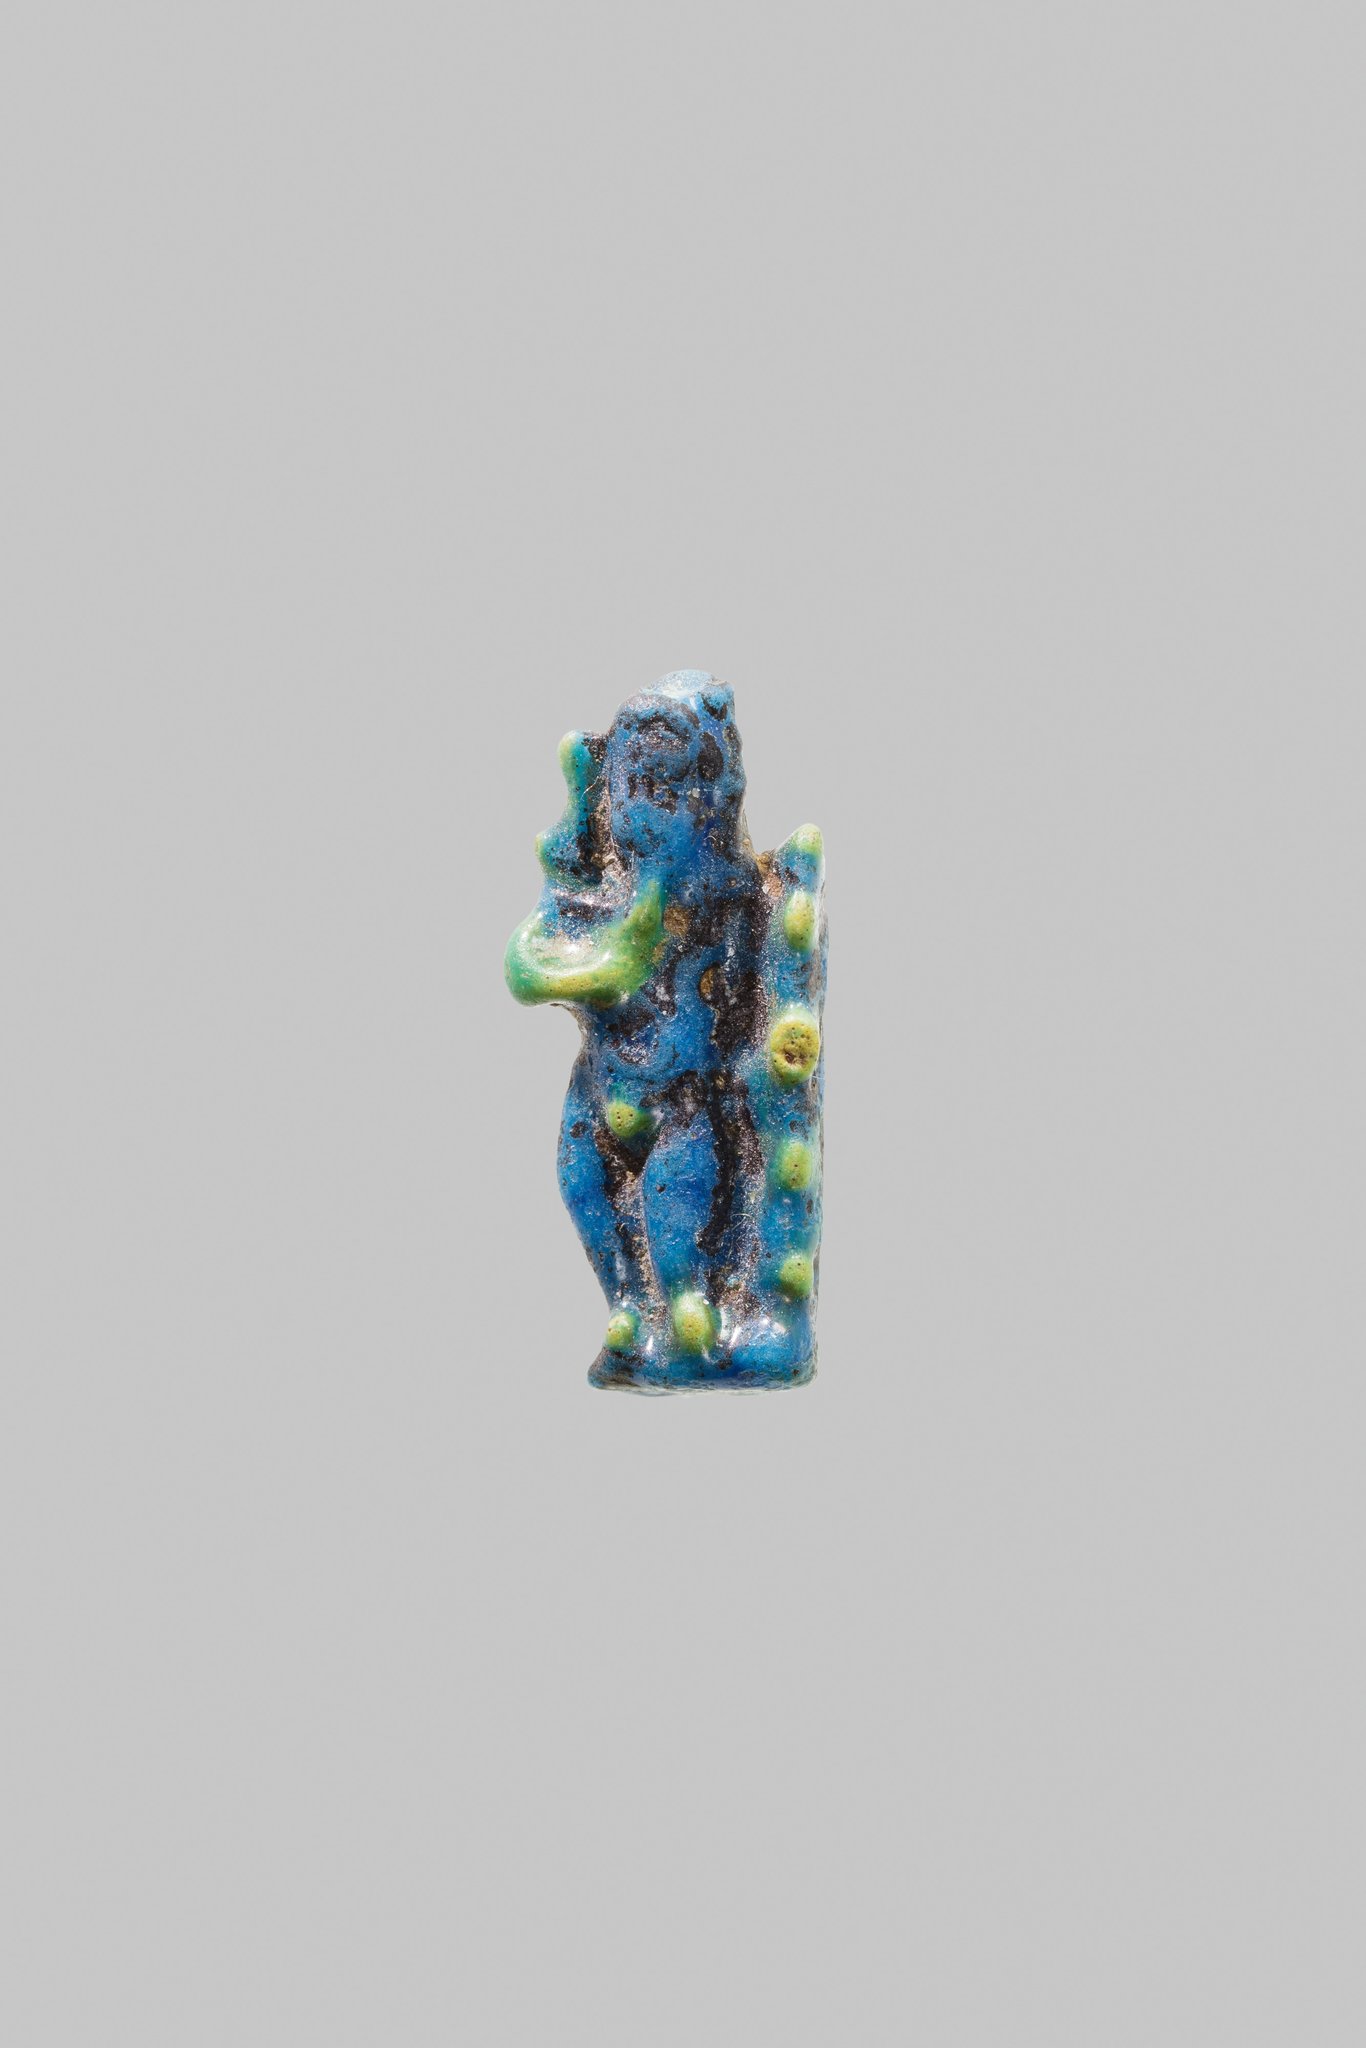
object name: figurine, harpokrates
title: Harpokrates figurine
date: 664-630 BCE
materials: faience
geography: egypt